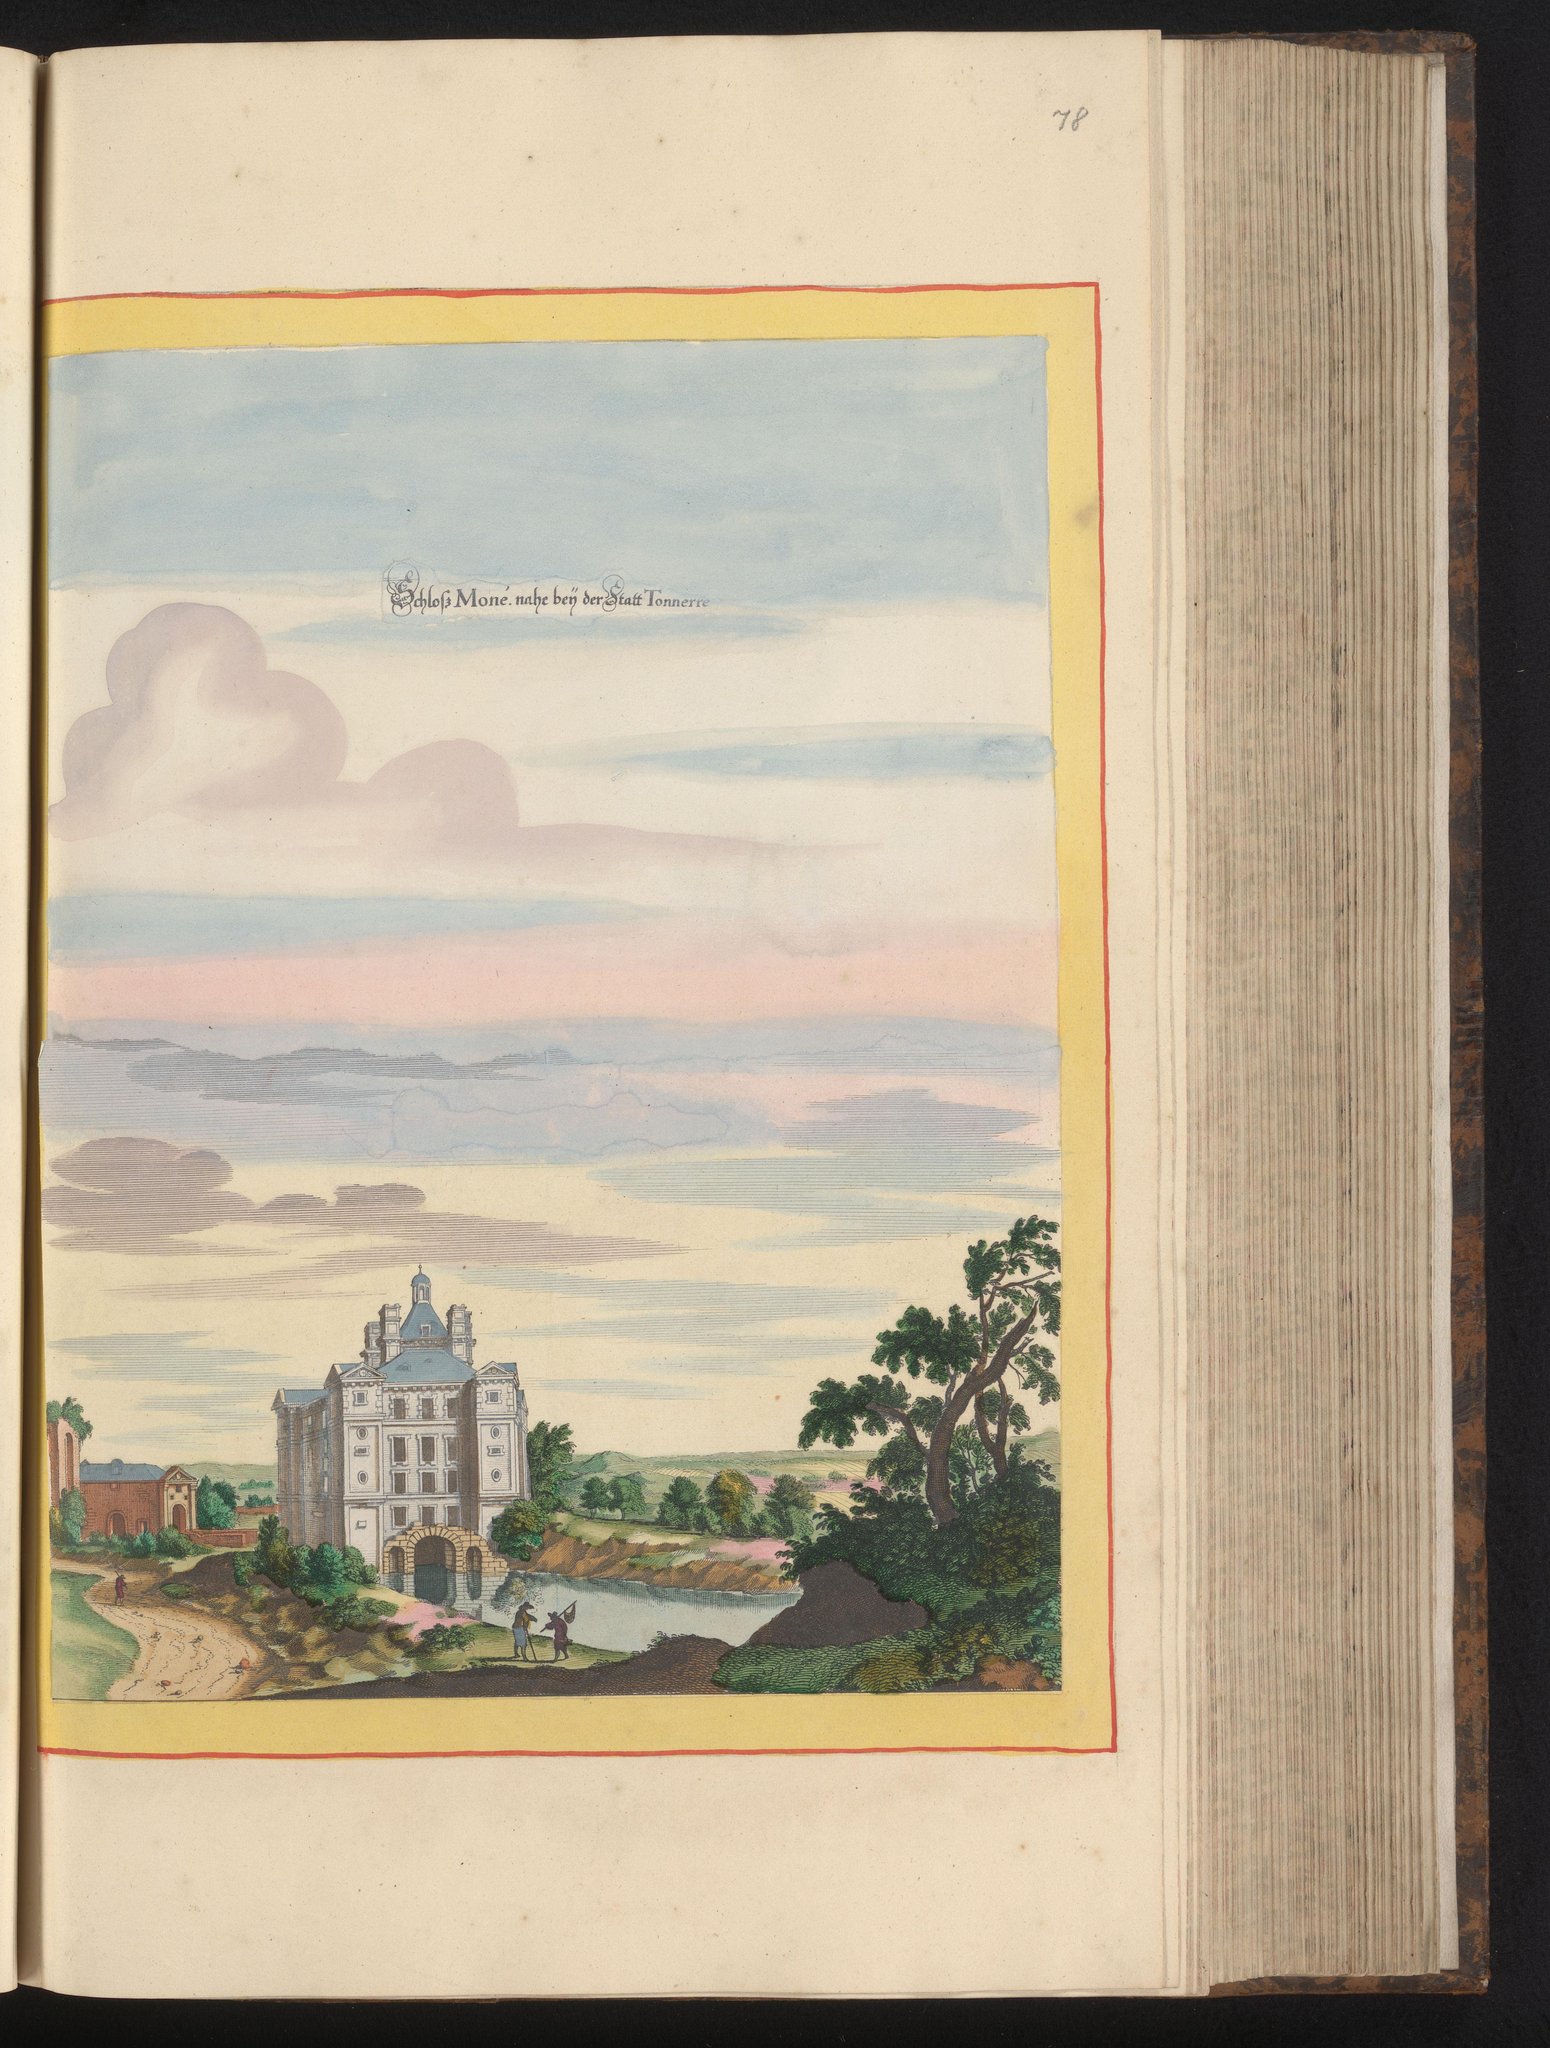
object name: print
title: Schloss Moné, nahe beij der Statt Tonnerre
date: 1656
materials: paper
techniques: engraving, etching, hand coloring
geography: frankfurt am main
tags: castle, landscape with tower or castle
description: Prent uit: Zeiller, Martin. Topographia Galliae. 13 dln. Frankfurt: Caspar Merian, 1656, dl. 3, na p. 18.